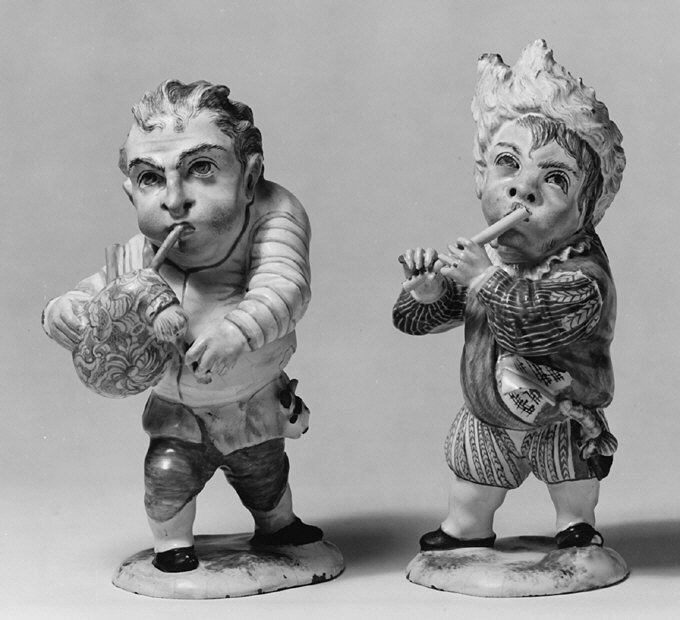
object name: figure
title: Dwarf musician (one of a pair)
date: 1750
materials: faience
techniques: glazing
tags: men,flutes